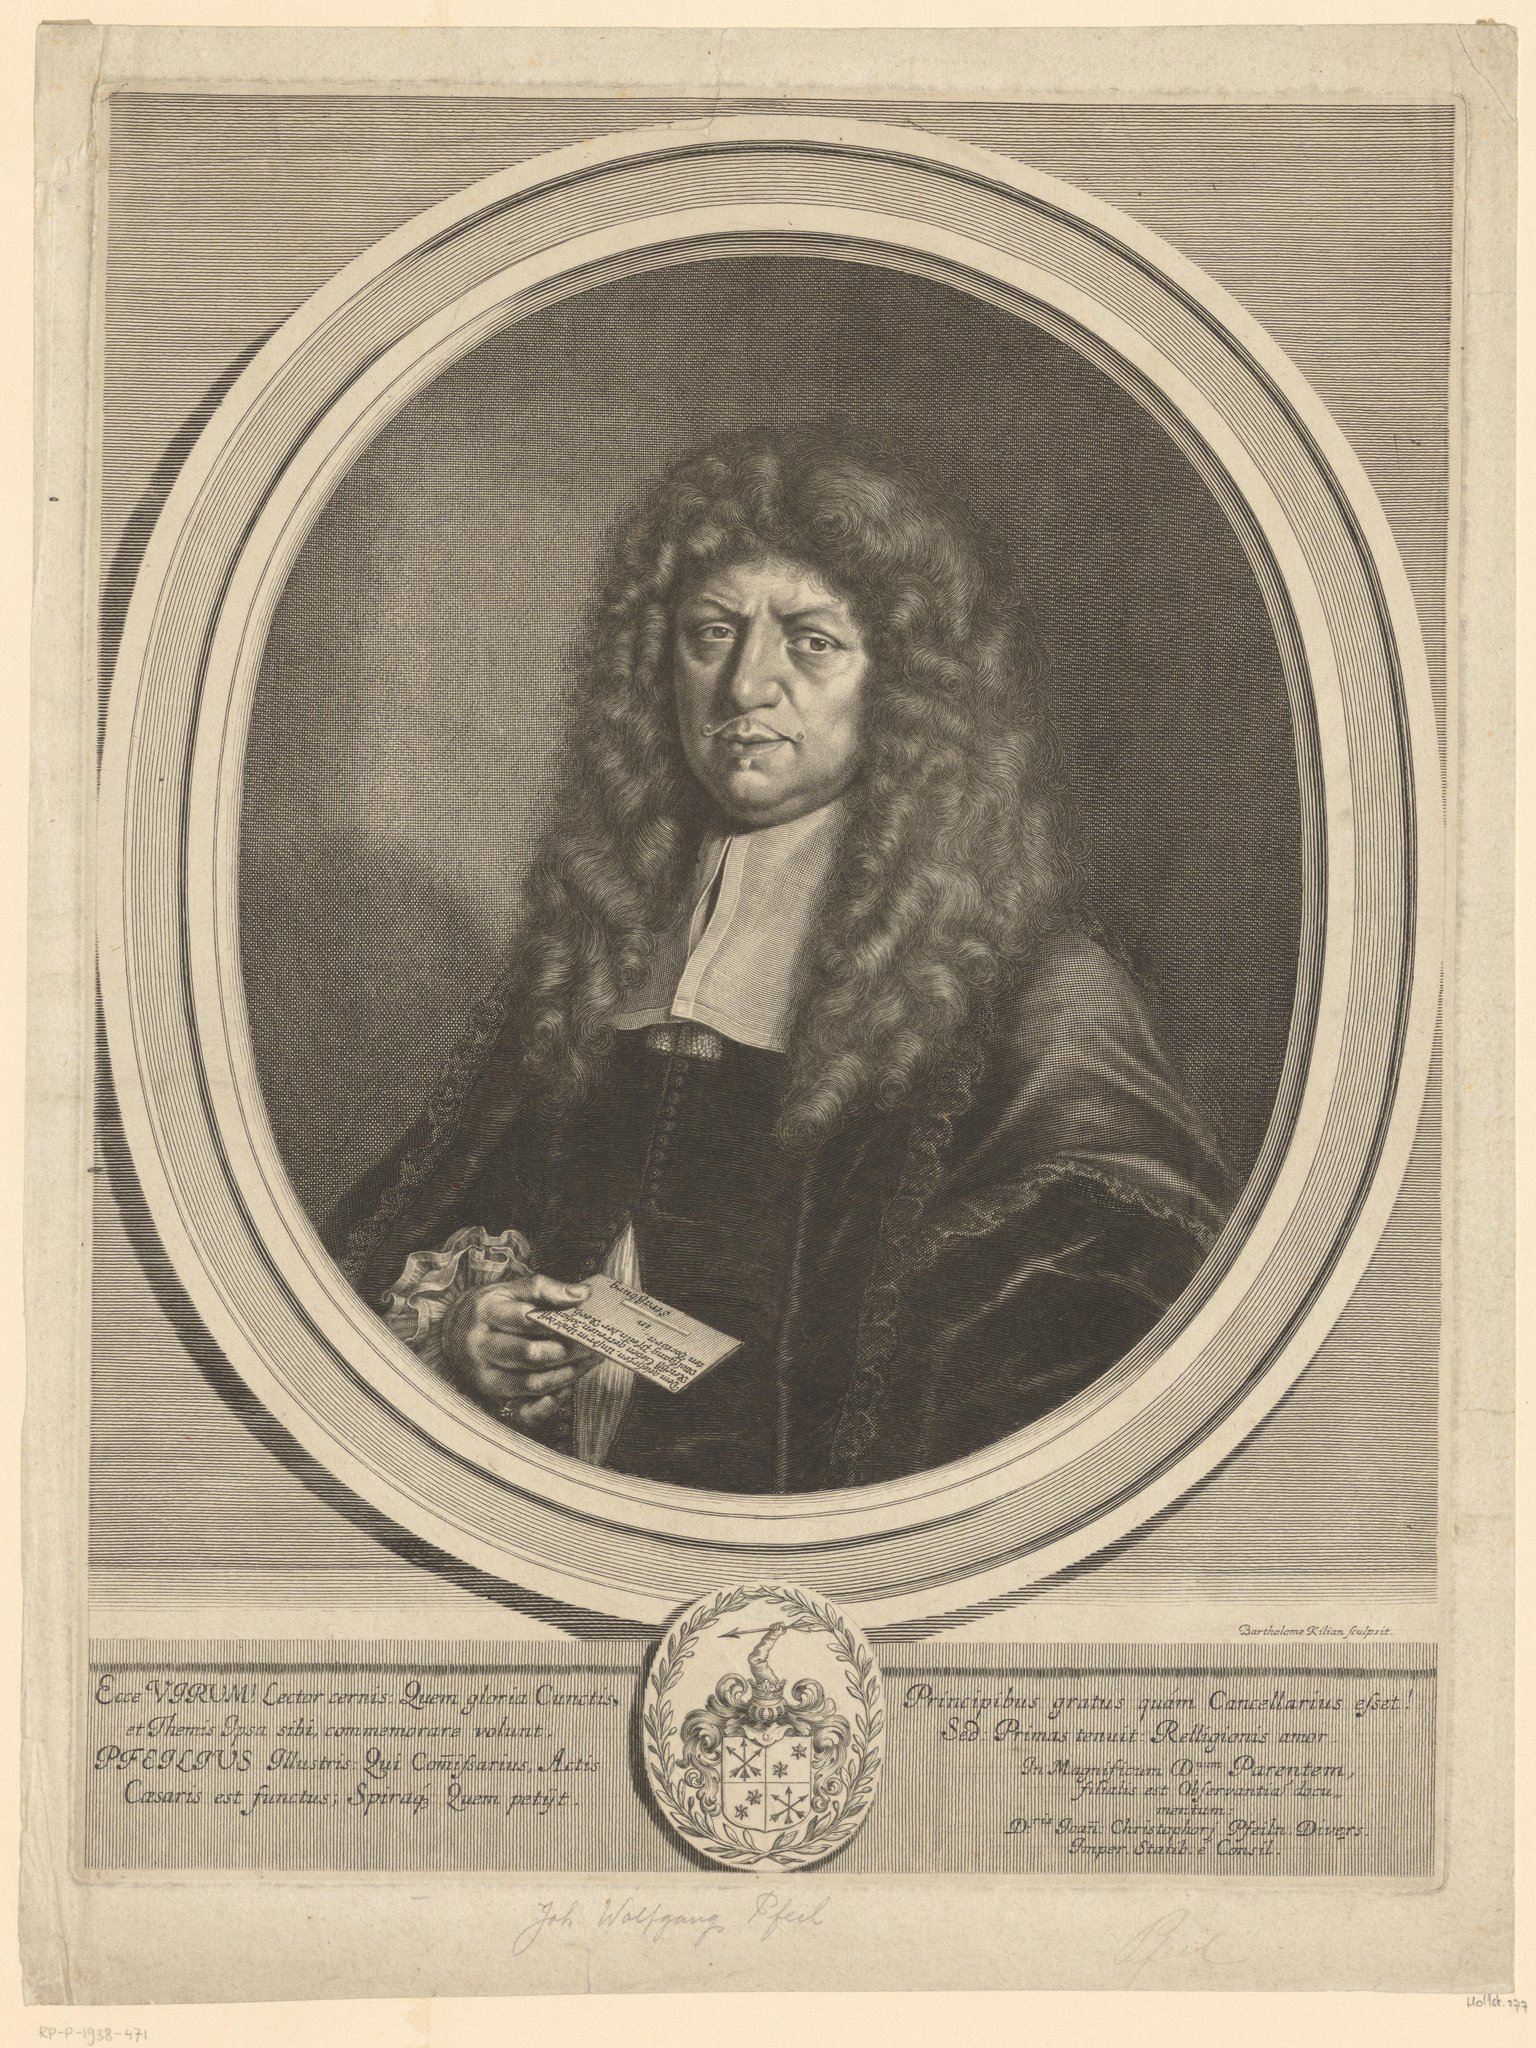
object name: print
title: Portret van Johann Wolfgang Pfeil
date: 1640-1696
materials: paper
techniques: engraving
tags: historical persons, lawyer, attorney at law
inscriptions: collector's mark: Lugt 2228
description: Tekst in het Latijn in de marge en tekst in het Duits op de brief.